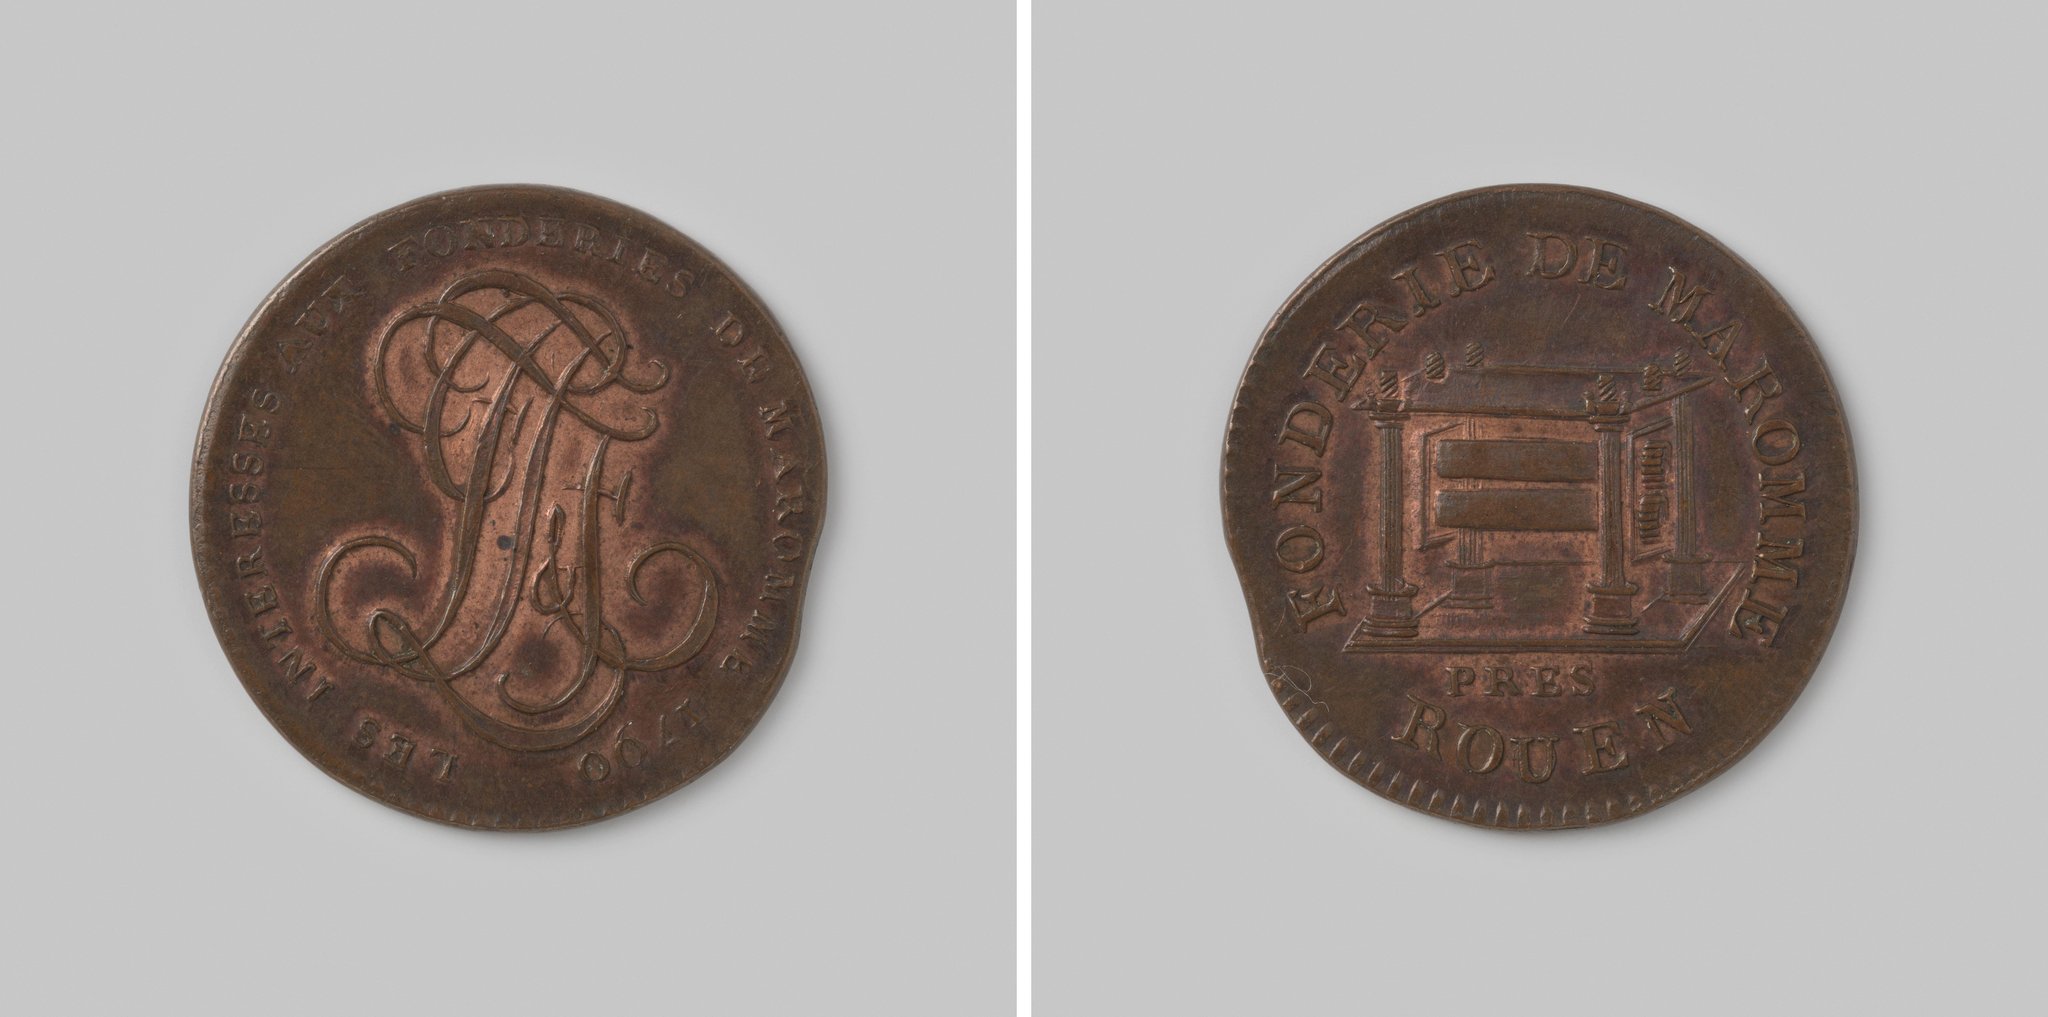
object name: siege coin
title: Reclamepenning en particuliere betaalpenning ('noodmunt') van de Fonderie de Maromme, 1790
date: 1790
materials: copper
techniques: striking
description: Koperen penning, op de voorzijde een wals met omschrift en afsnedetekst, op de keerzijde een monogram met omschrift.